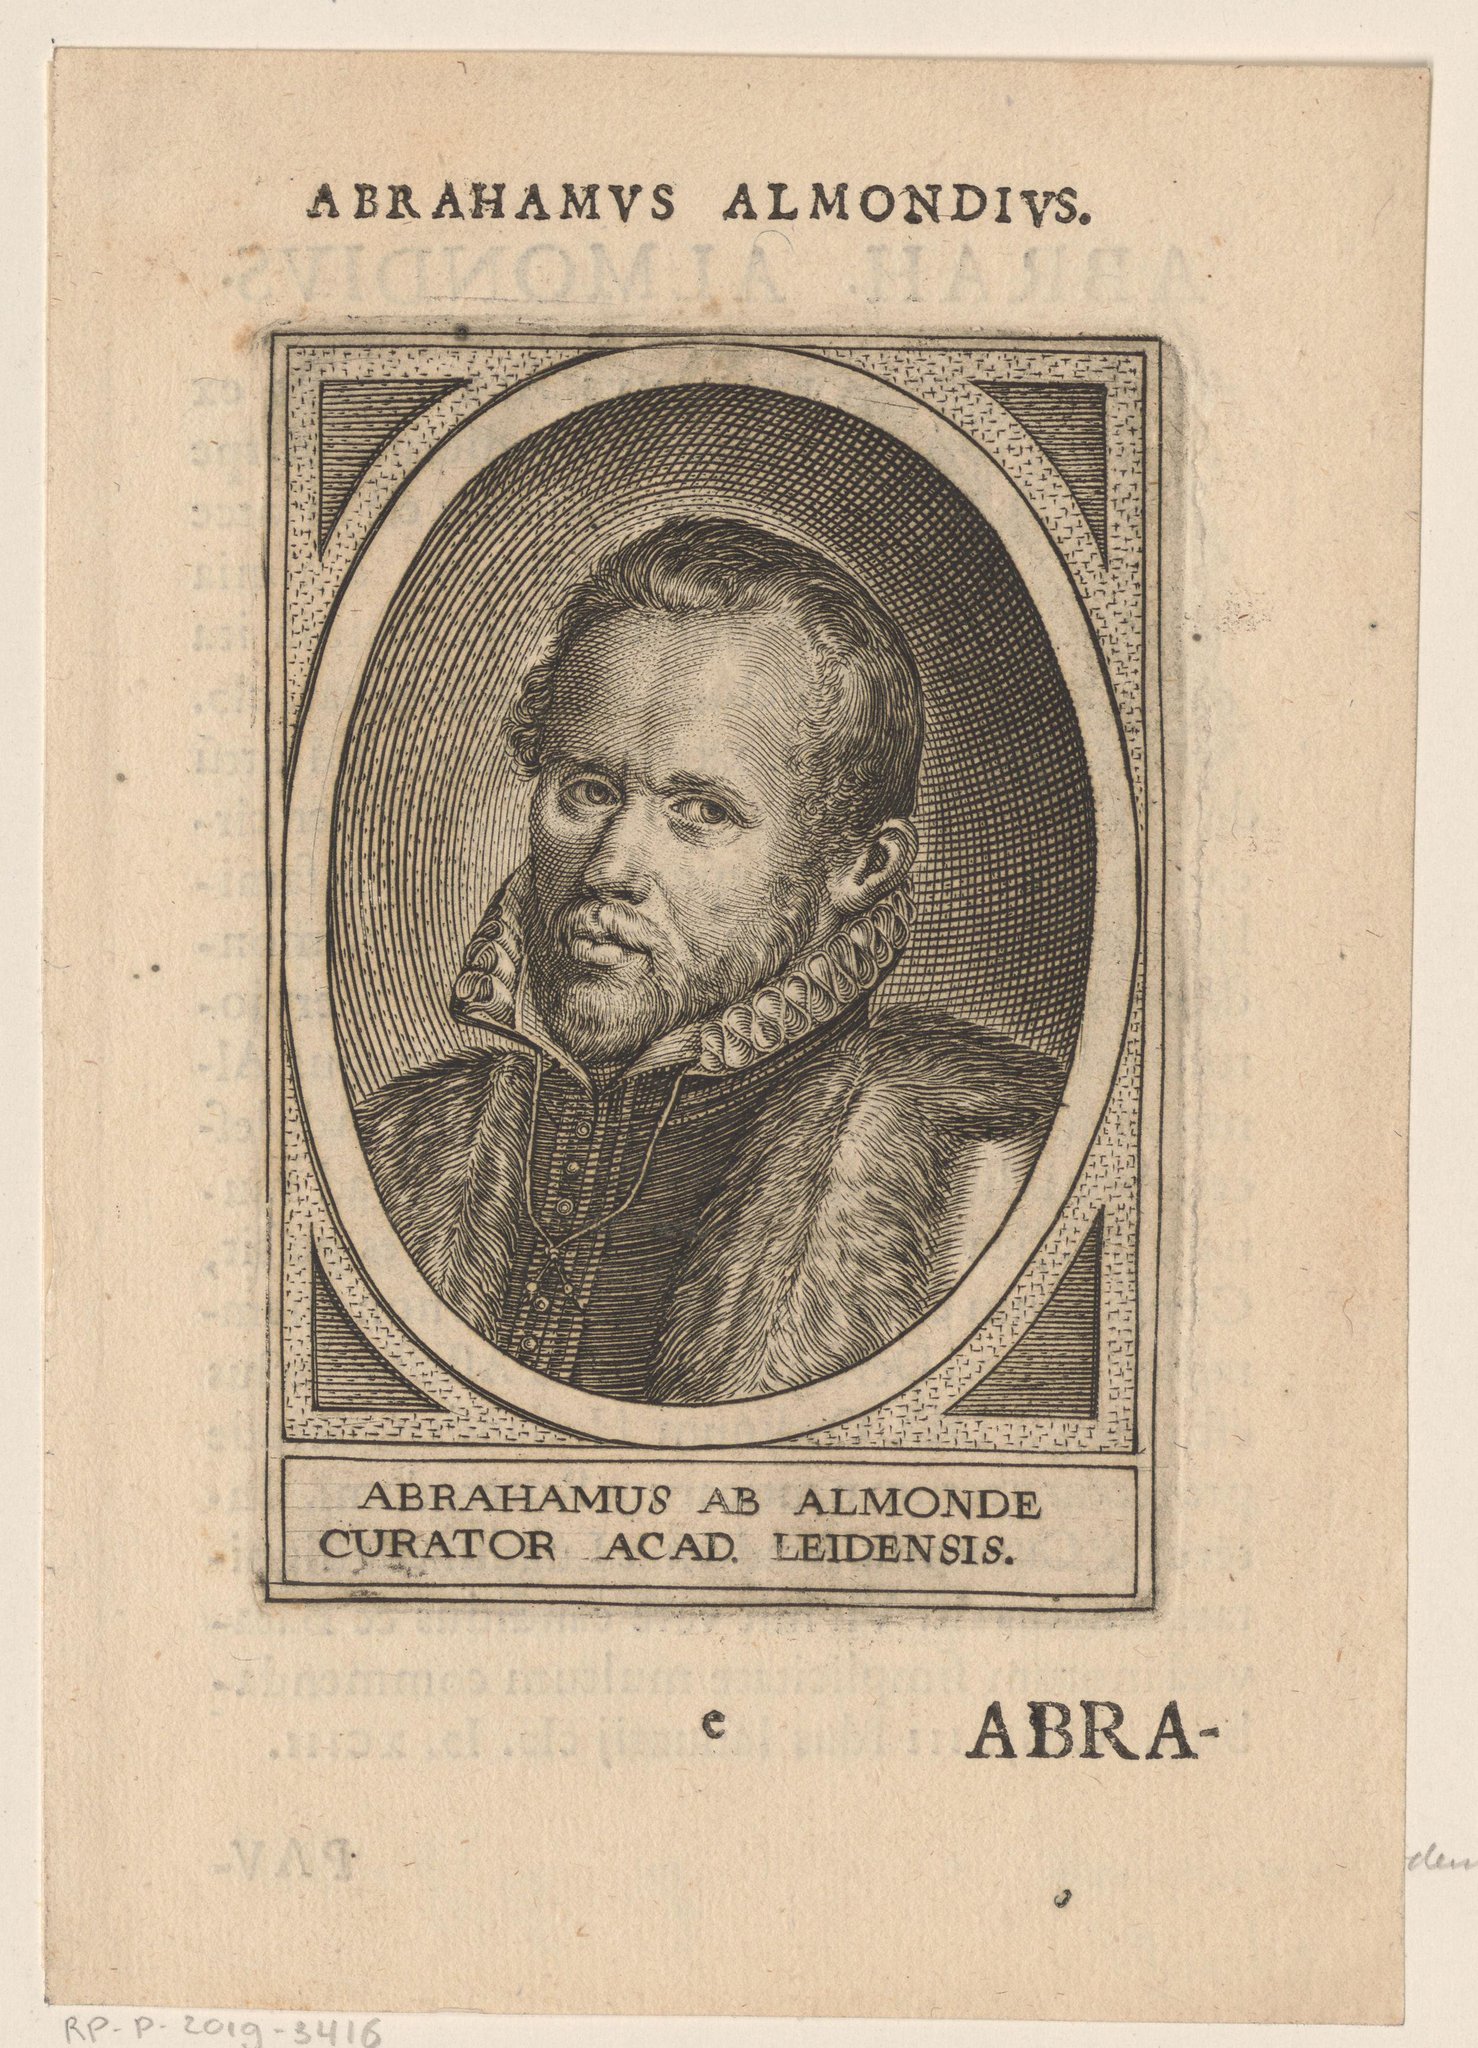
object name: print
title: Portret van Abraham van Almonde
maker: Anonymous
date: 1614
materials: paper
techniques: engraving, etching, letterpress printing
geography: leiden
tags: delft, politician, mayor, historical persons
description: Prent uit: Meursius, Joannes. Illustrium Hollandiae & Westfrisiae ordinum alma academia Leidensis. Leiden: Jacob Marcus en Joost van Colster, 1614.